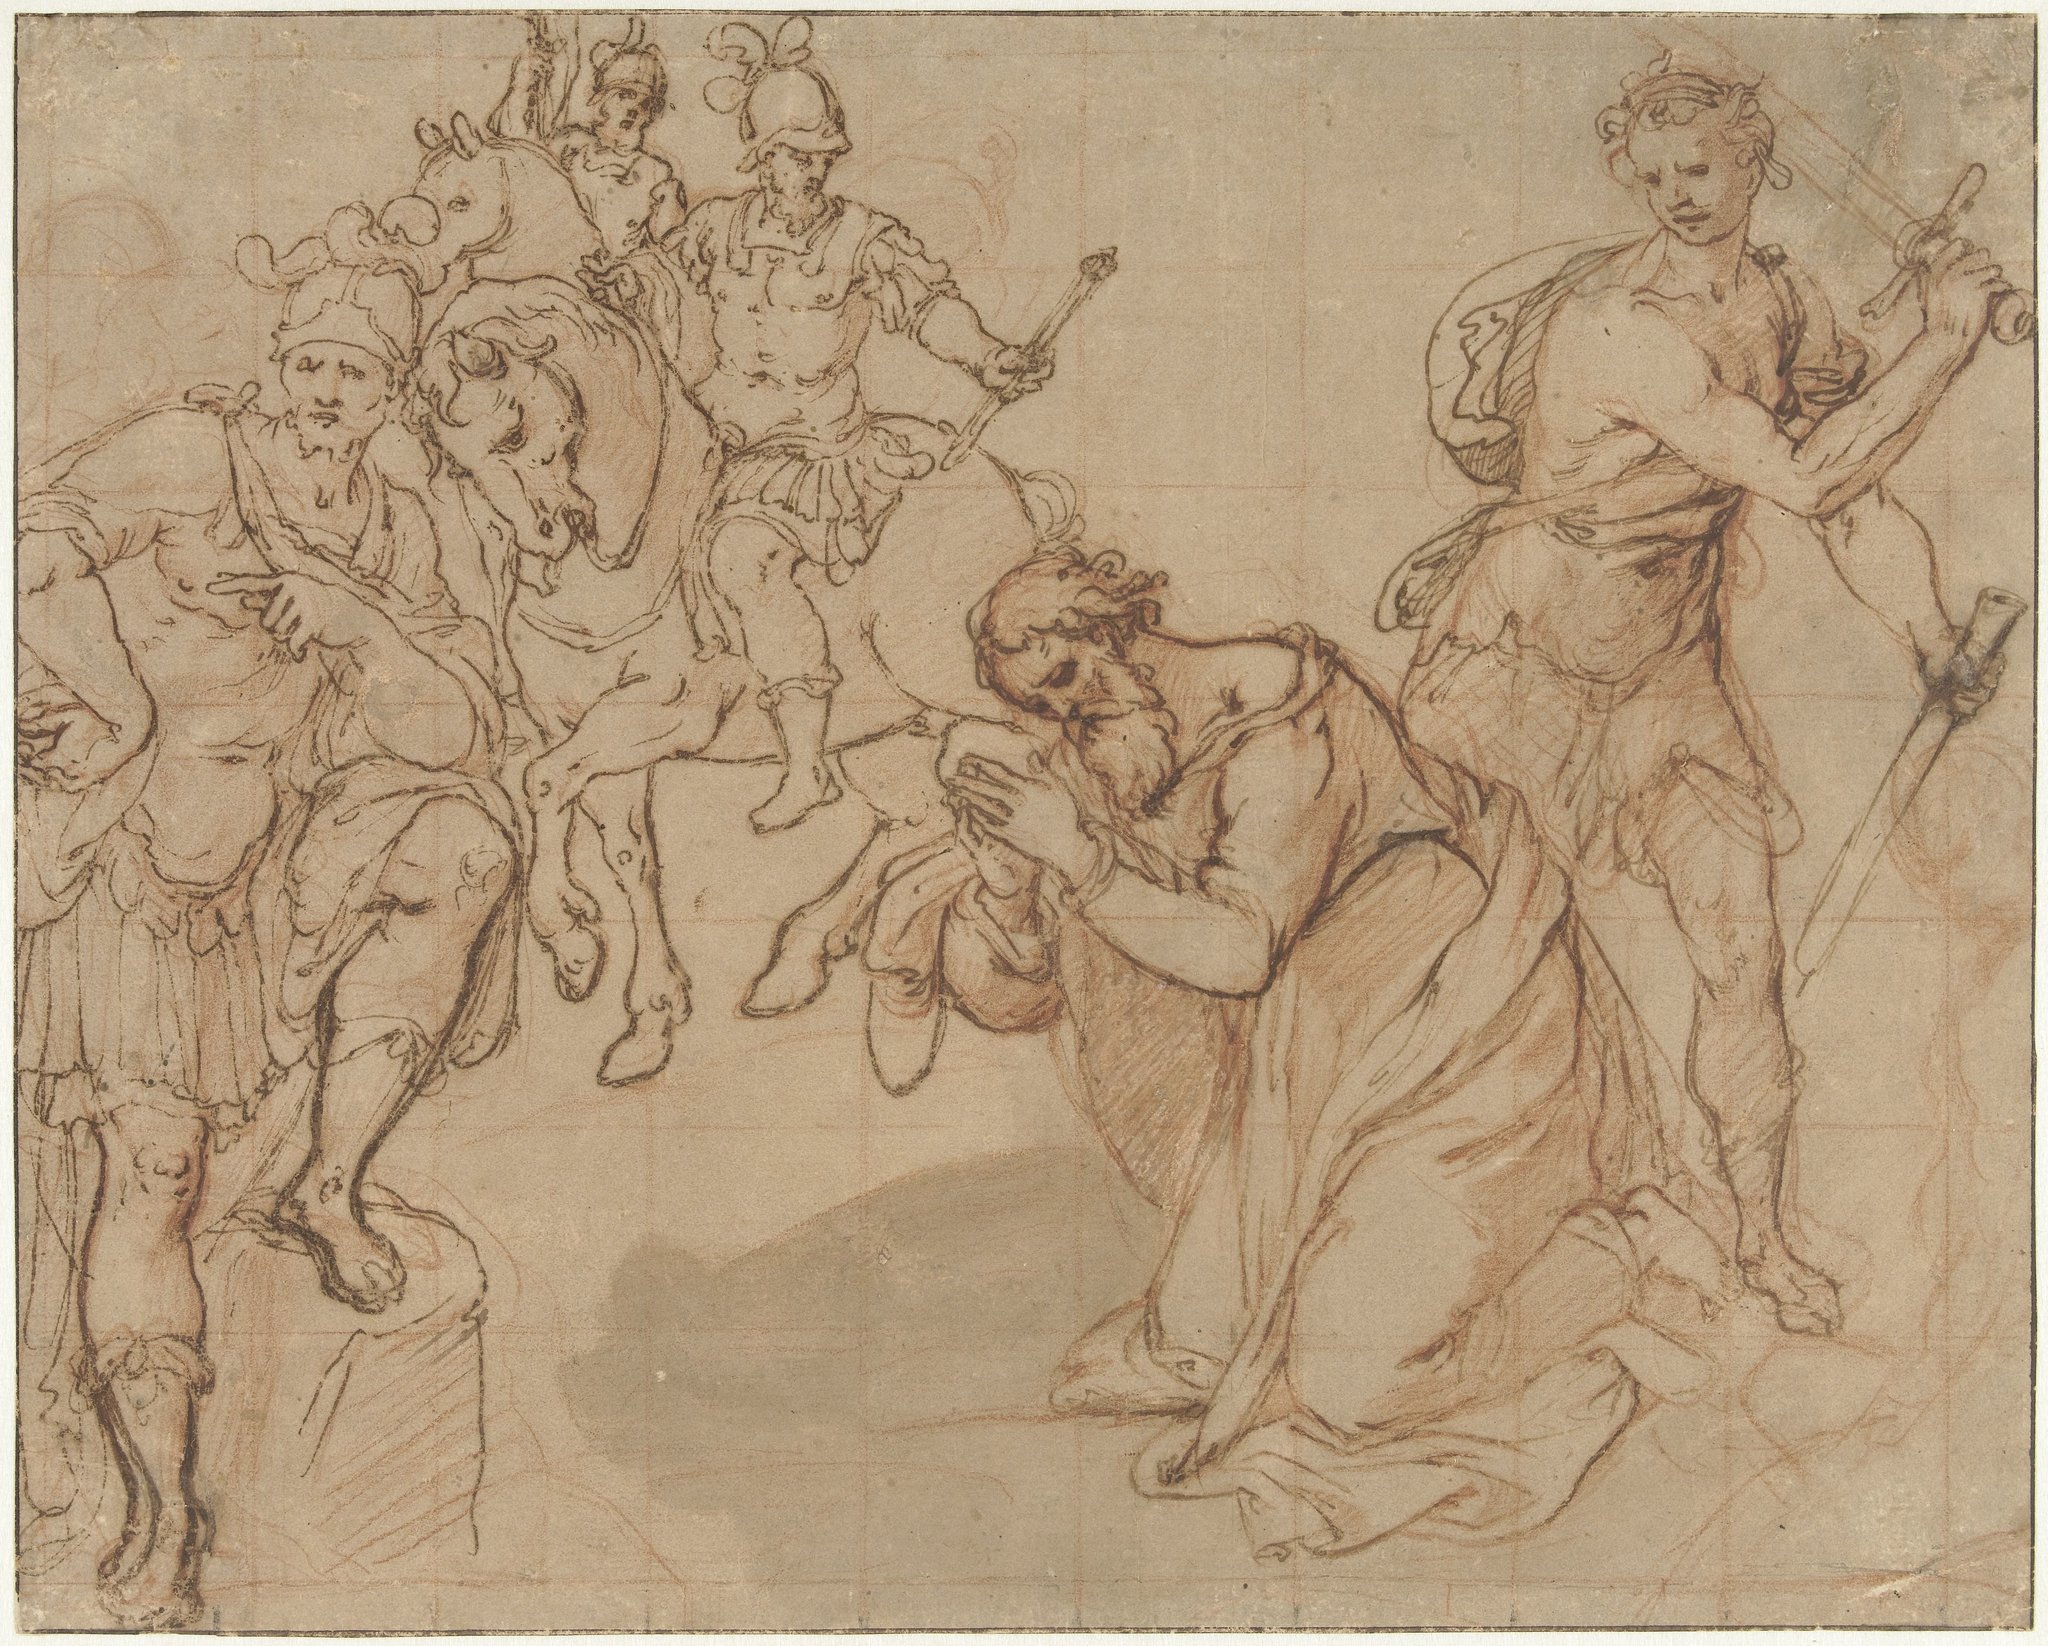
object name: drawing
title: Onthoofding van Paulus met twee ruiters op de achtergrond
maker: avanzino nucci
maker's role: draughtsman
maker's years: 1551-1629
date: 1561-1629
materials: chalk, ink, paper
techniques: pen, drawing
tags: the beheading of paul; maybe three fountains spring from his head